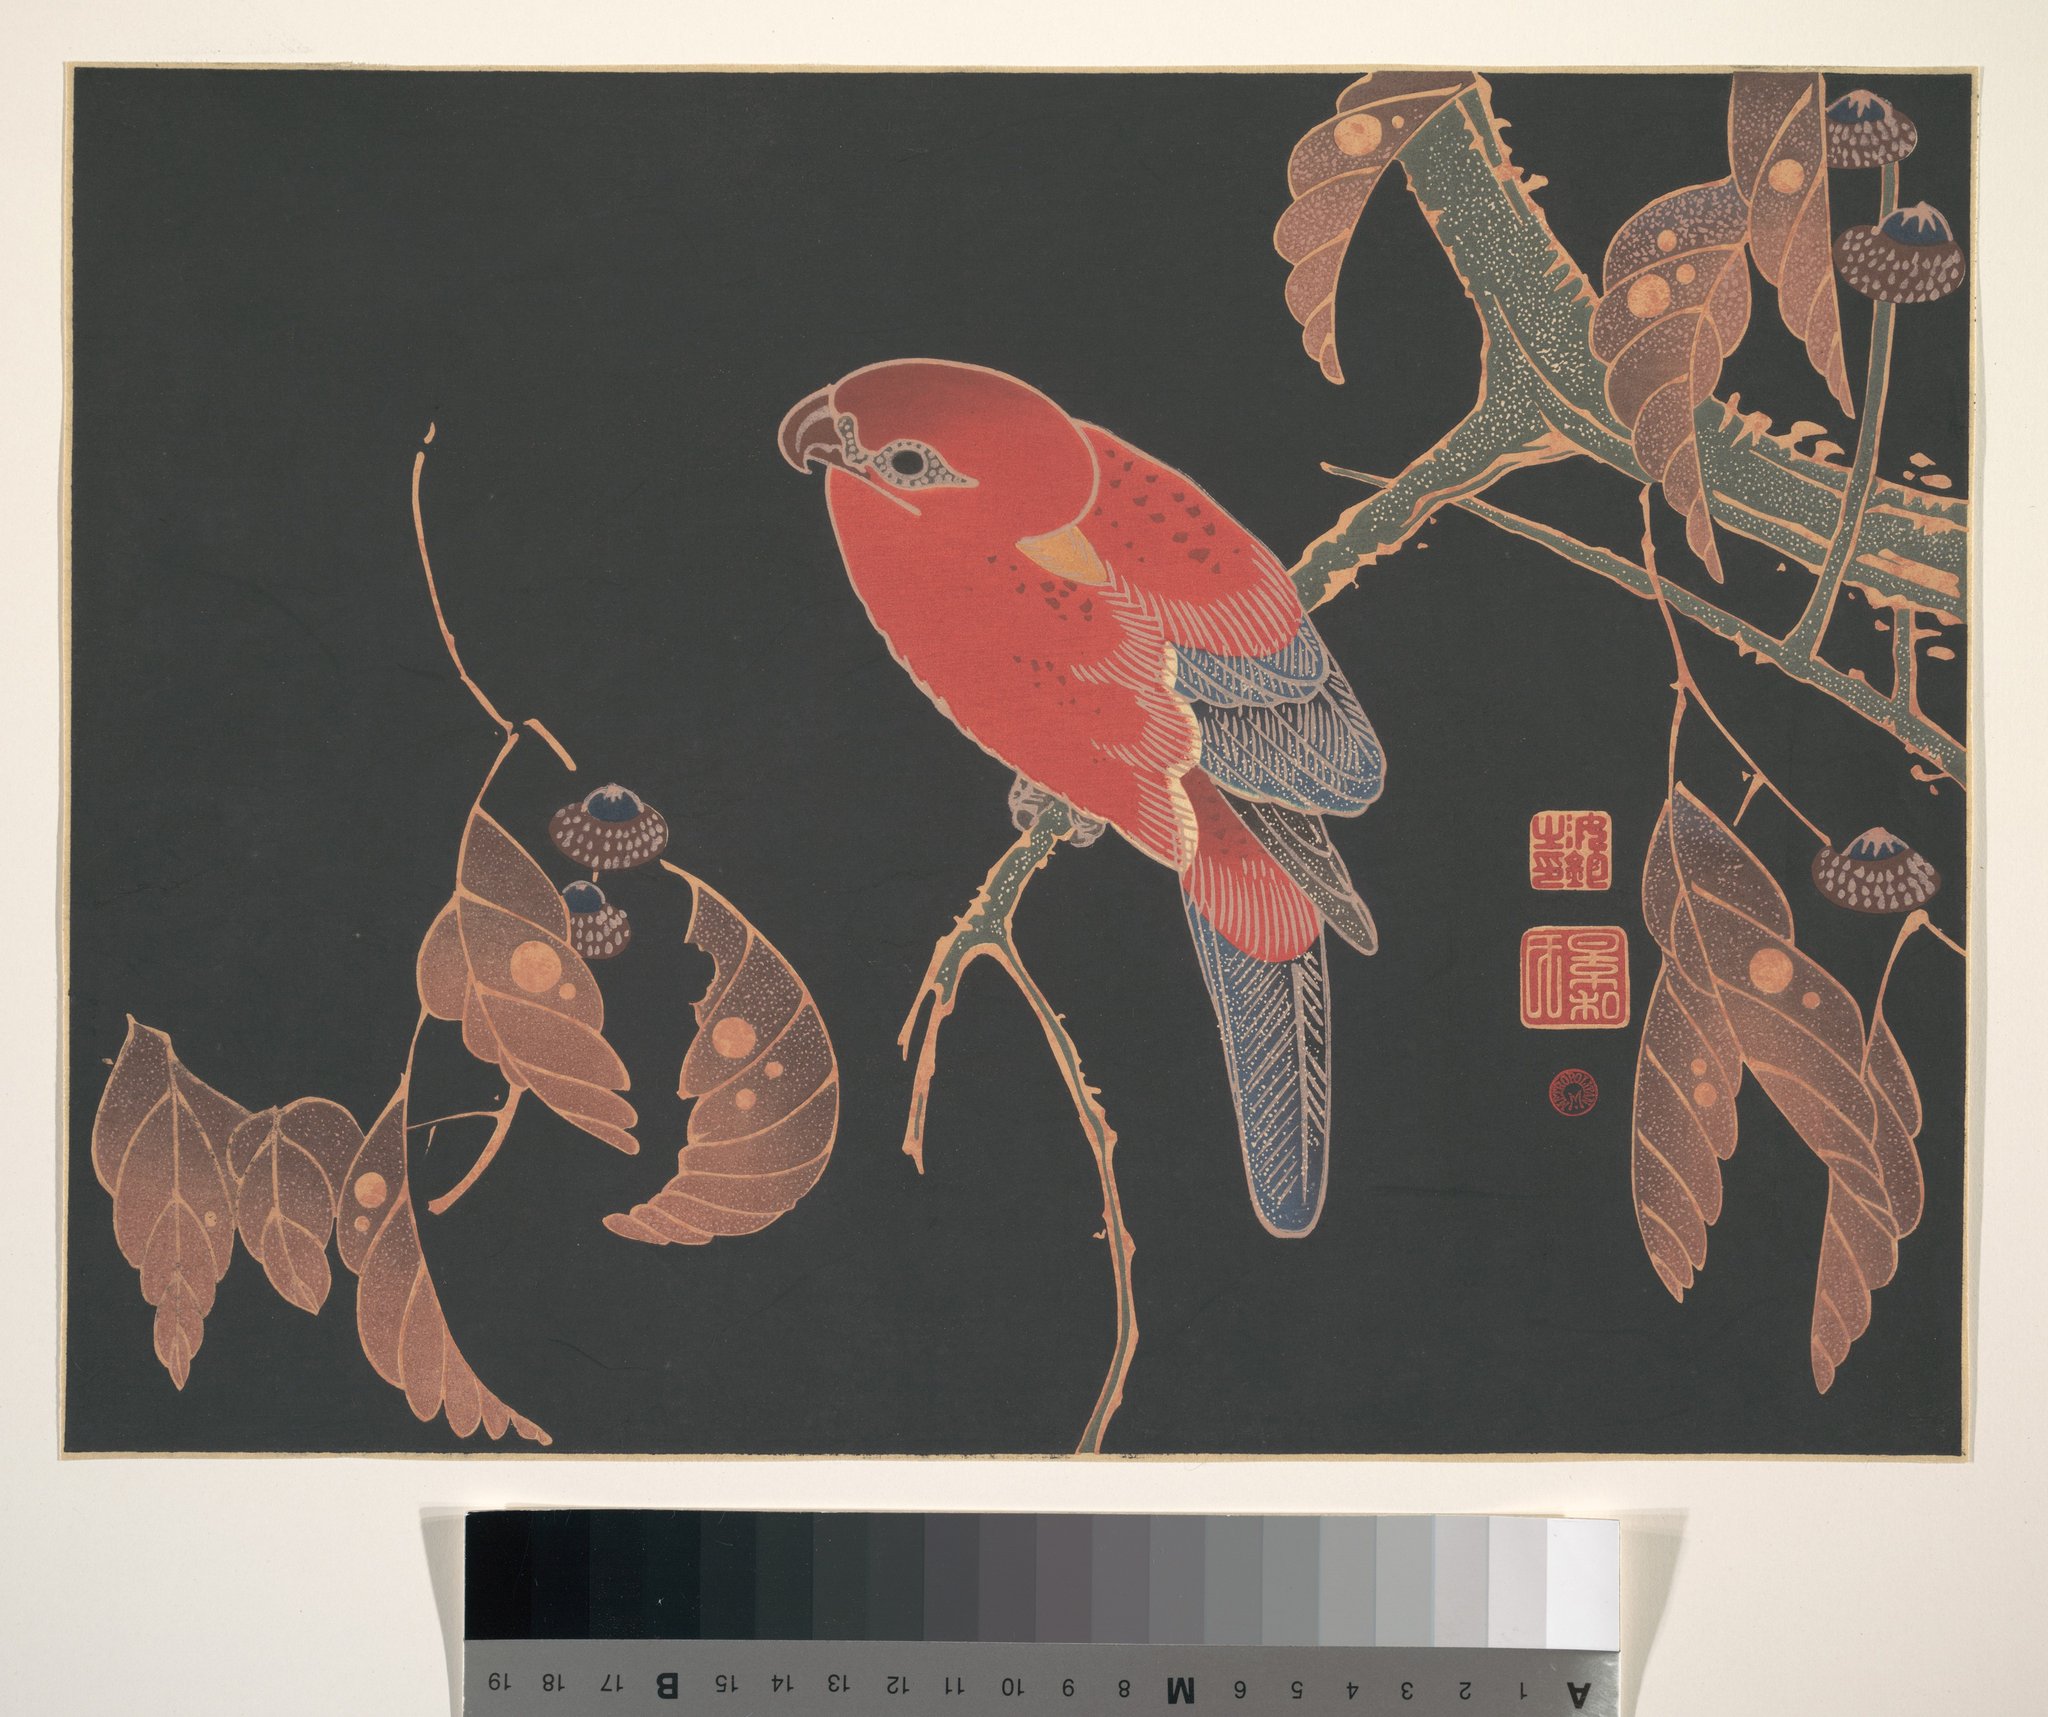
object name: reproduction of a print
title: Red Parrot on the Branch of a Tree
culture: japanese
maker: itō jakuchū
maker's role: artist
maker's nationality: japanese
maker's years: 1716-1800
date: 1900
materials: ink, paper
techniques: woodblock print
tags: parrots,leaves